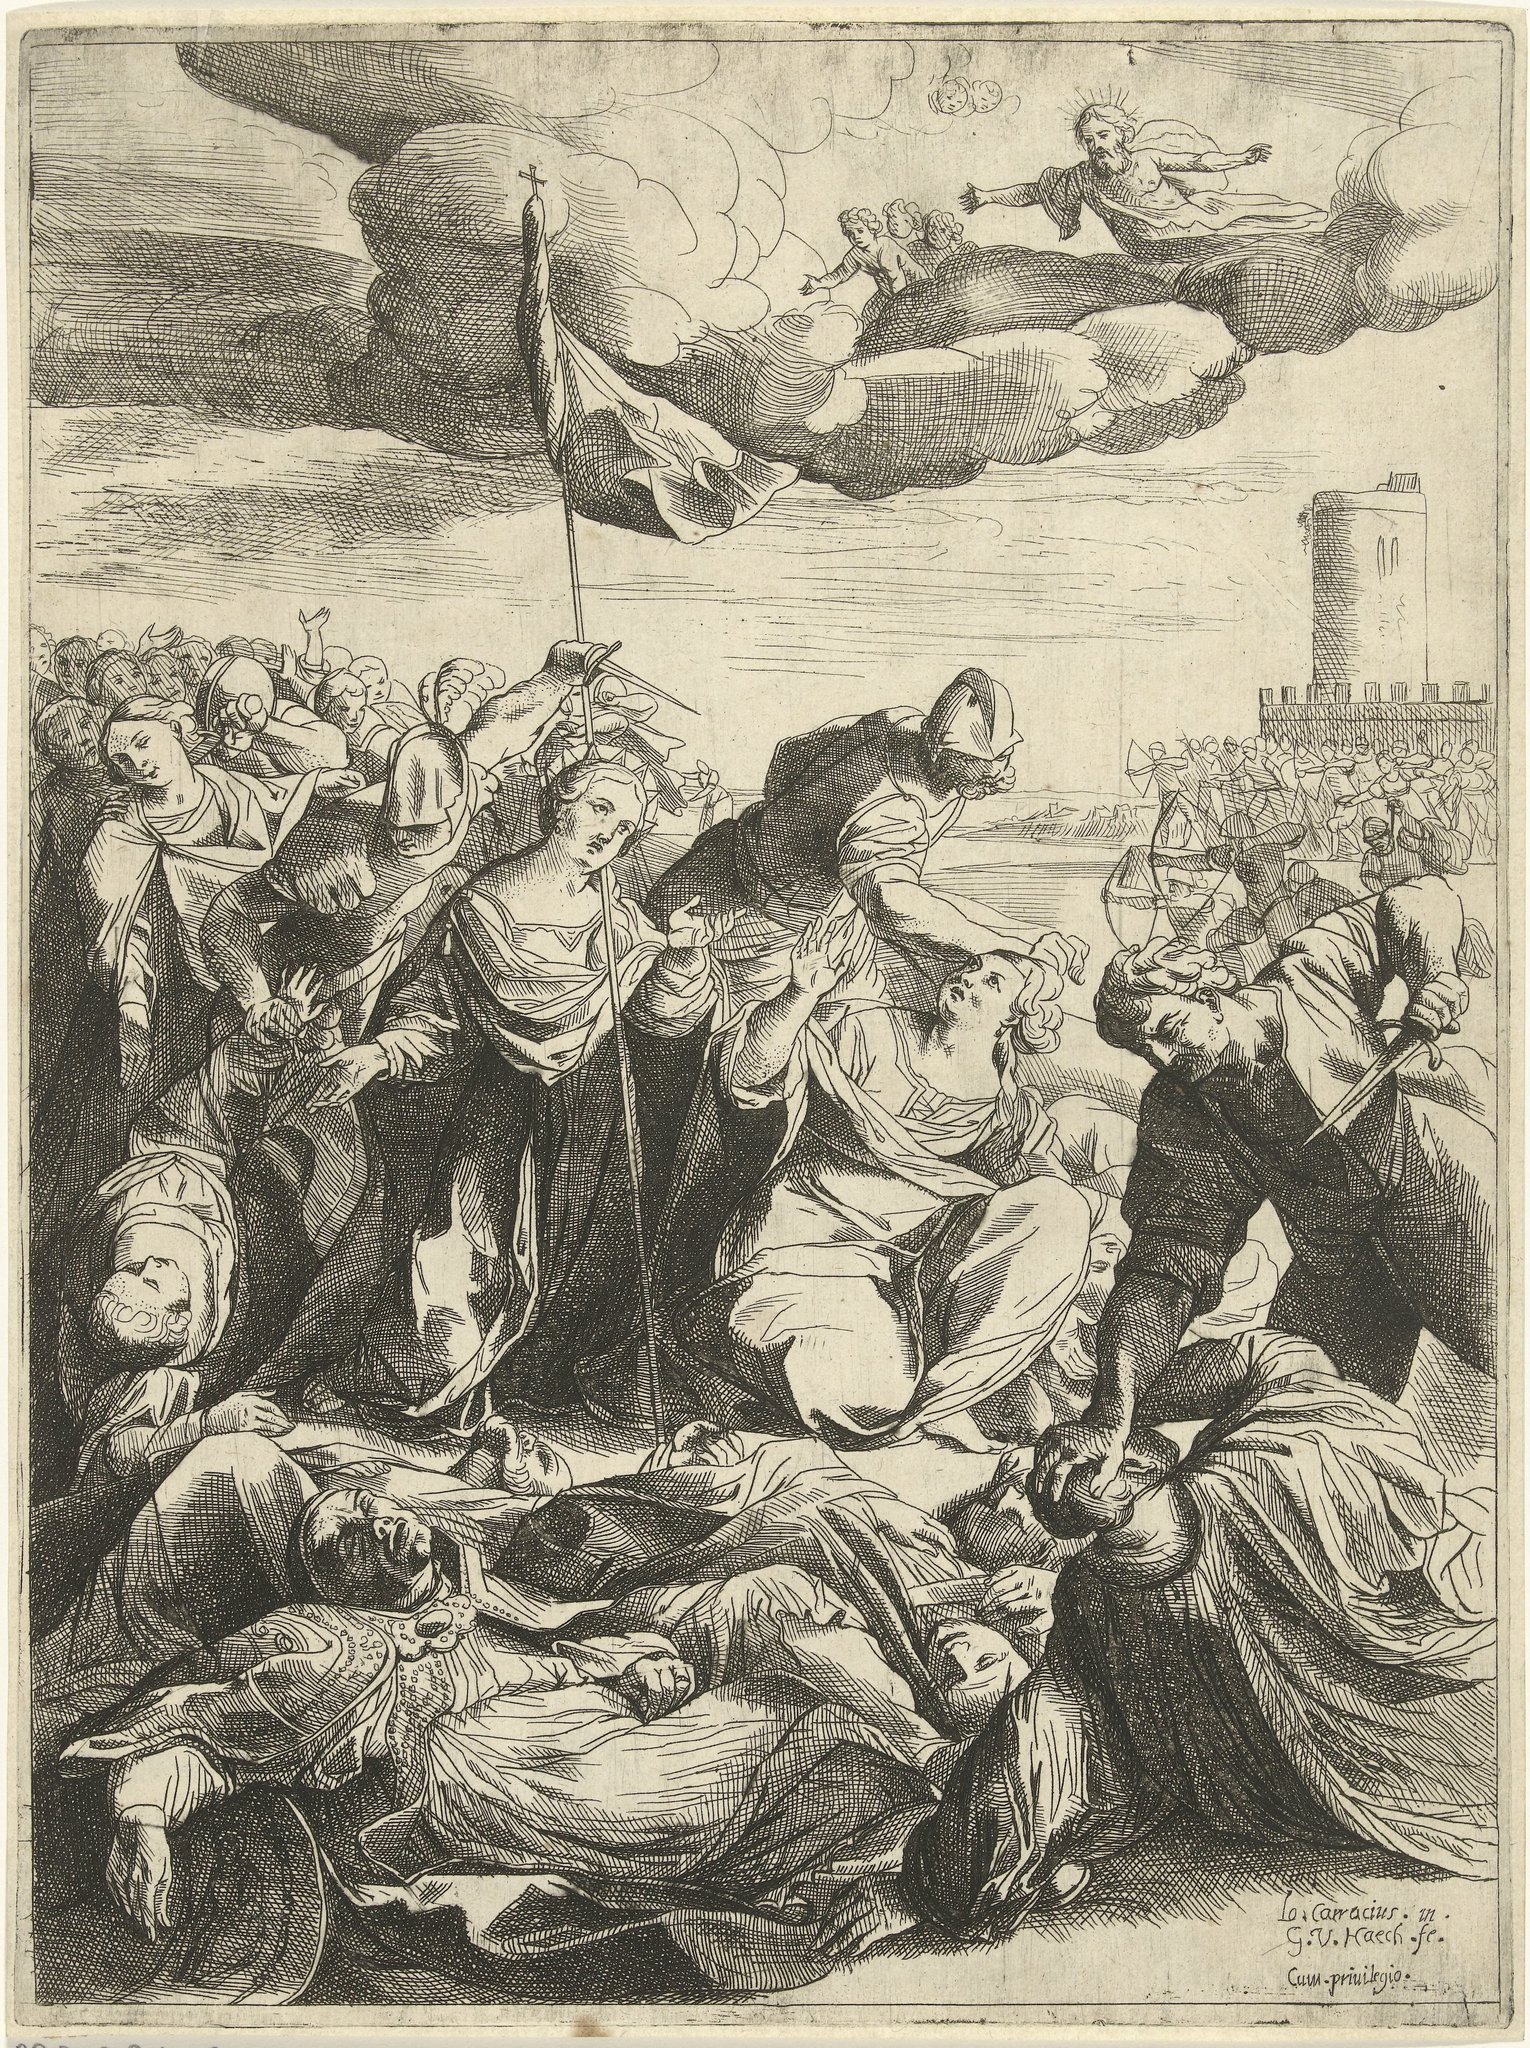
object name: print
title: Heilige Ursula belegerd door de Hunnen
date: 1603-1637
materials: paper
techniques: etching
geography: antwerp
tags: st. ursula and her companions are killed by the huns outside the walls of cologne; st. ursula dies by an arrow, while the maidens are killed by arrows, spears or swords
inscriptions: collector's mark: Lugt 2228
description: Ursula met kroon en pelgrimsstaf met christelijke banier temidden van soldaten die haar maagden doden. Op de achtergrond schieten soldaten met pijl en boog bij een toren (van de stad Keulen?). In de lucht tussen wolken God of Christus met enkele putti.